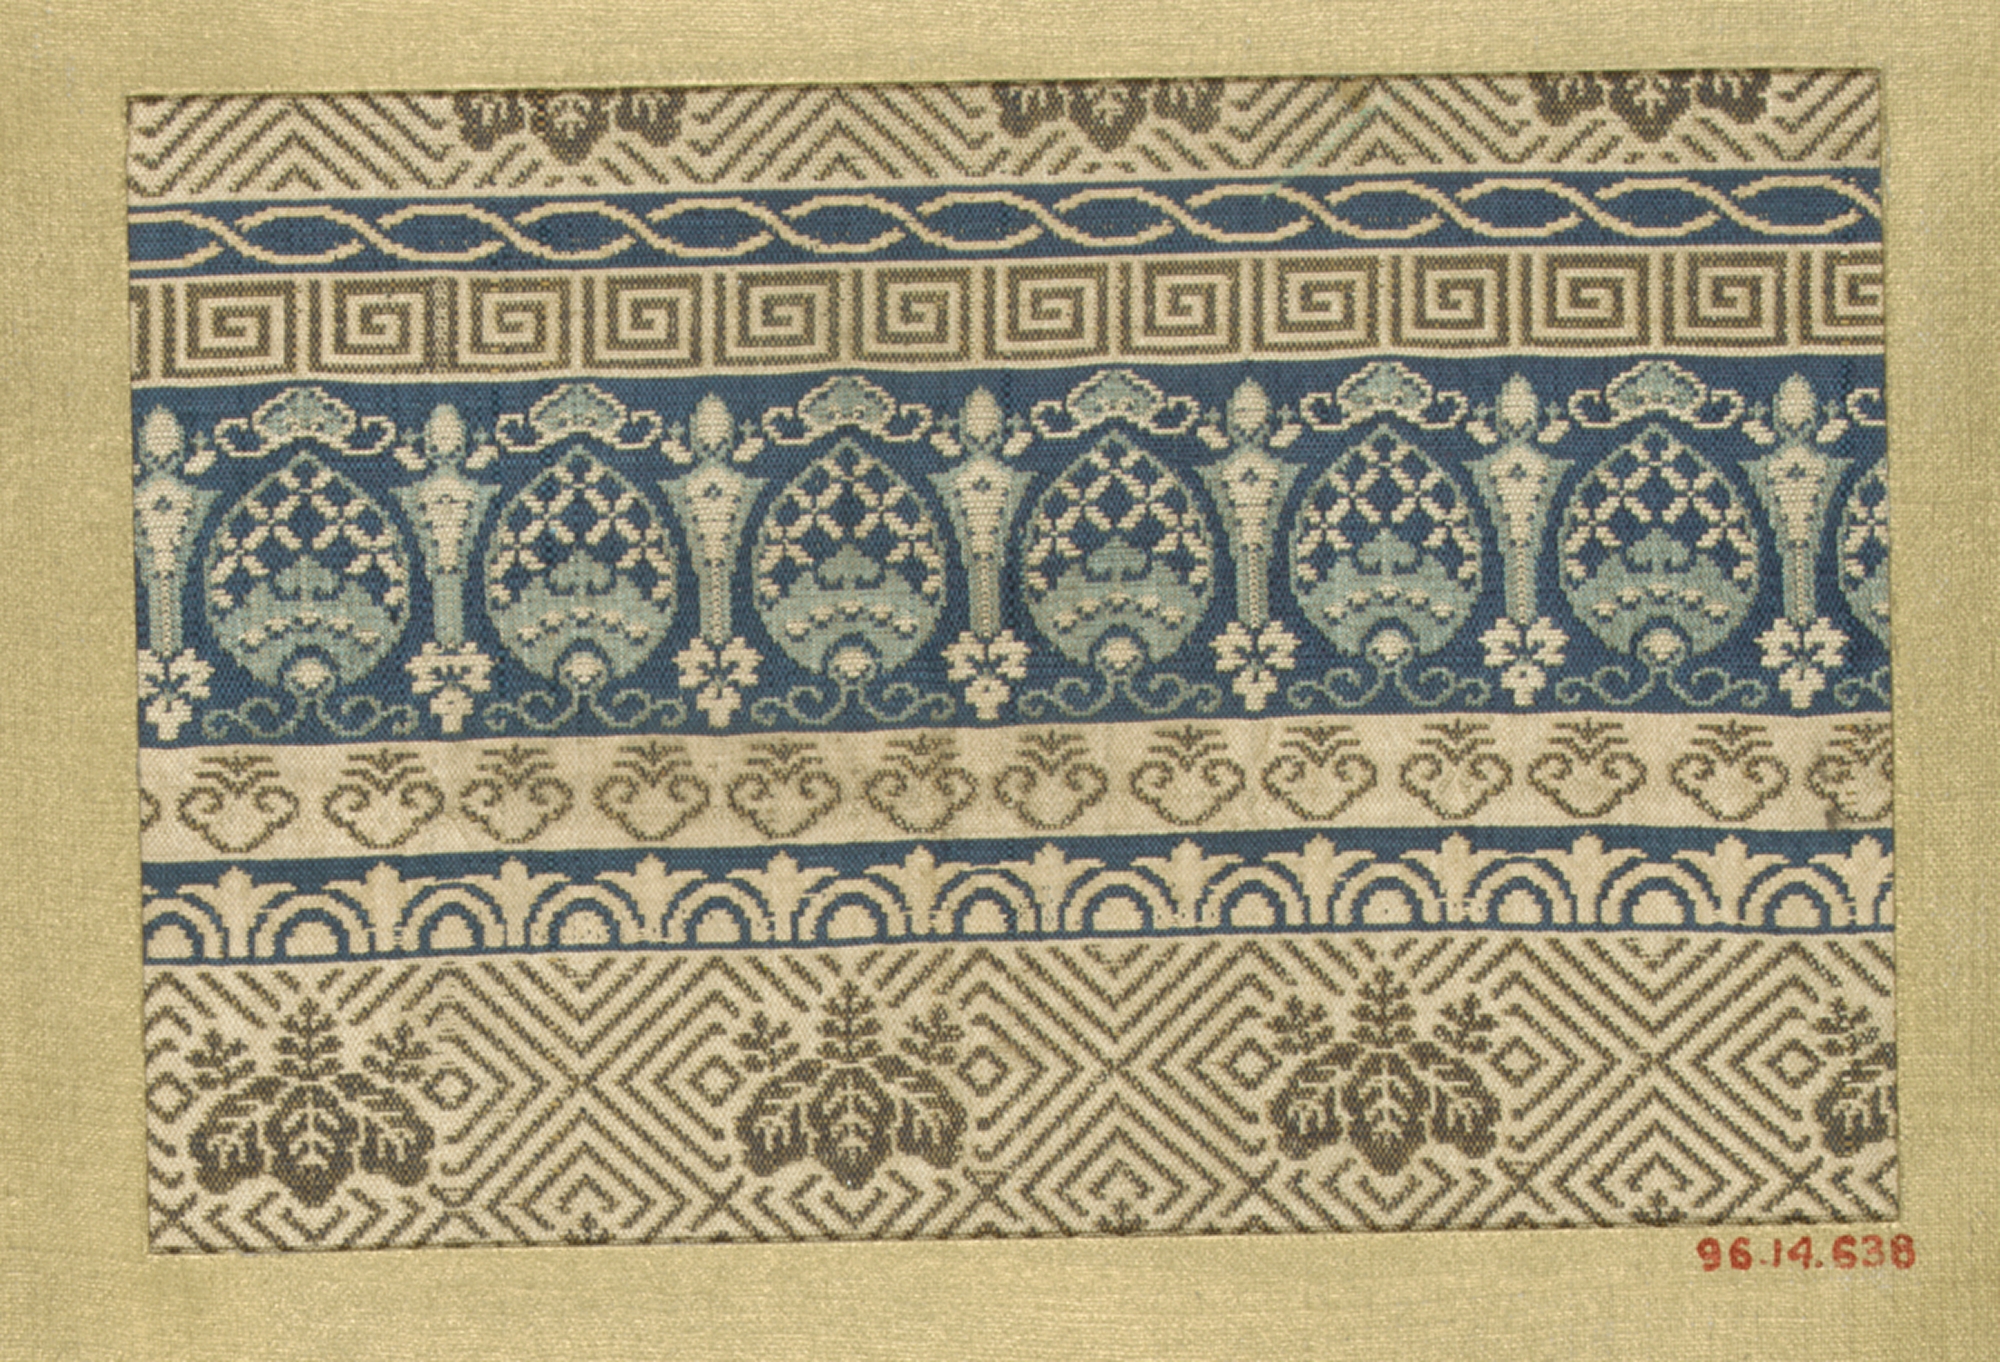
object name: piece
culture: japanese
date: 1701-1900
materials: silk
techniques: brocade